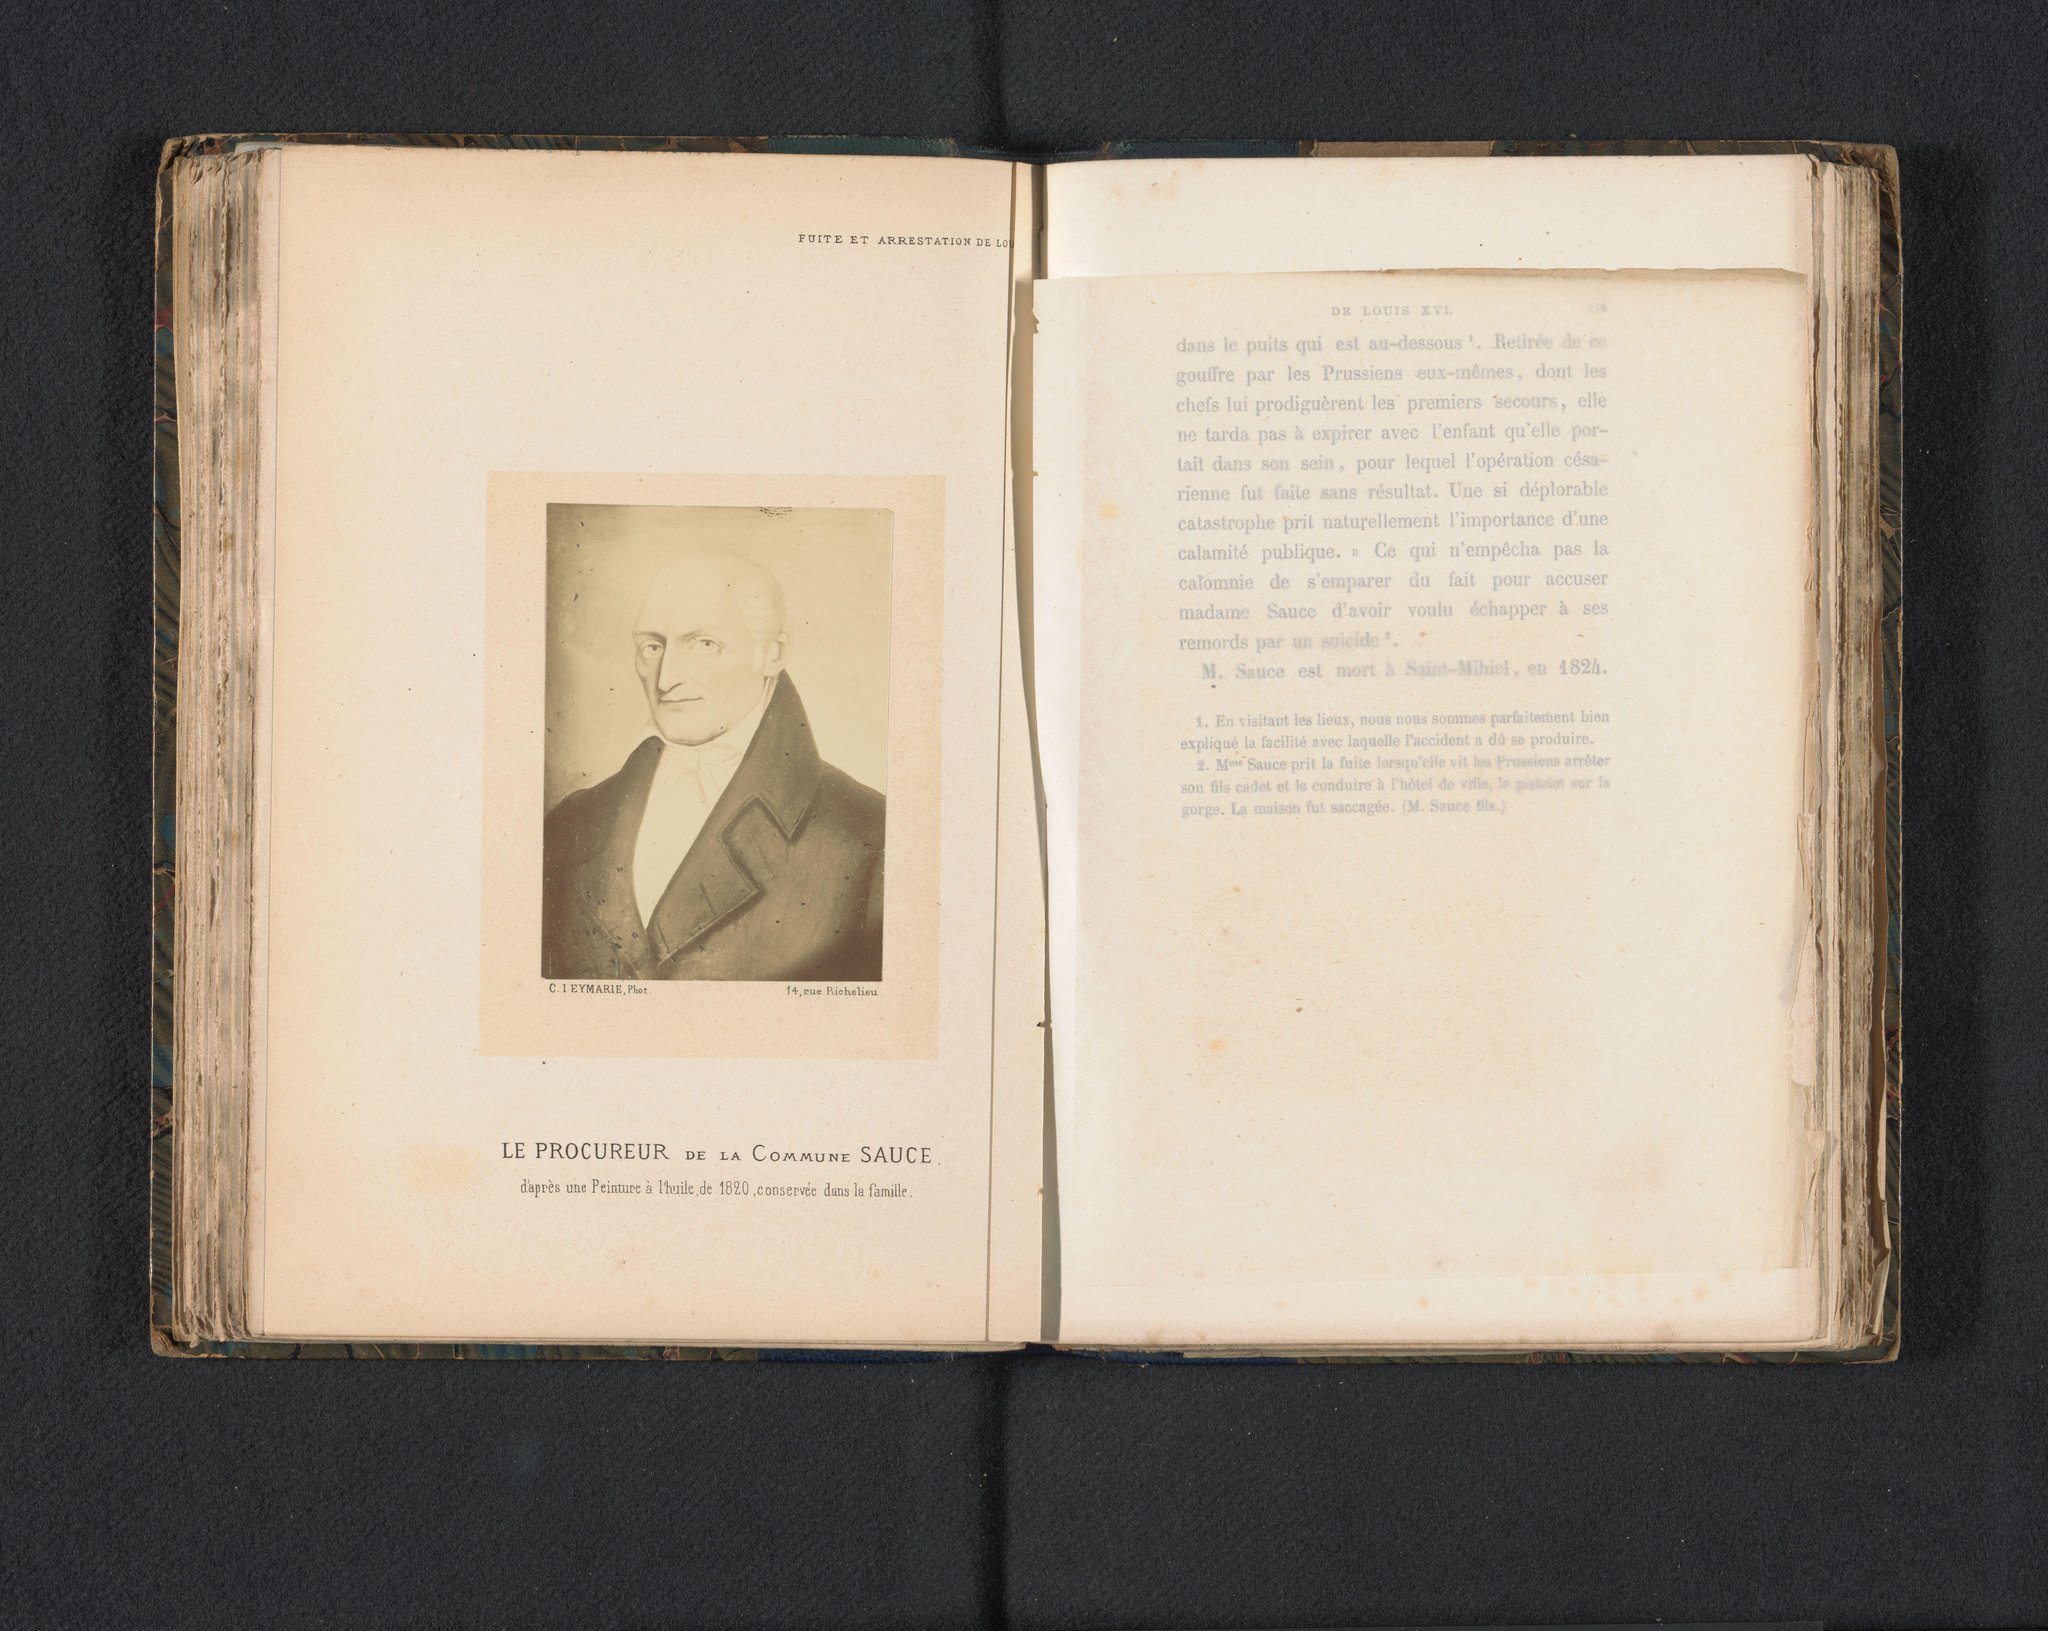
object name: page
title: Le procureur de la comune Sauce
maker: charles leymarie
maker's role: fotograaf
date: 1861-1866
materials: photographic support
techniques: albumen print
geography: sainte-menehould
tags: historical persons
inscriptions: inscription: ‘d'après une Peinture à l'huile, de 1820, conservée dans la famille’